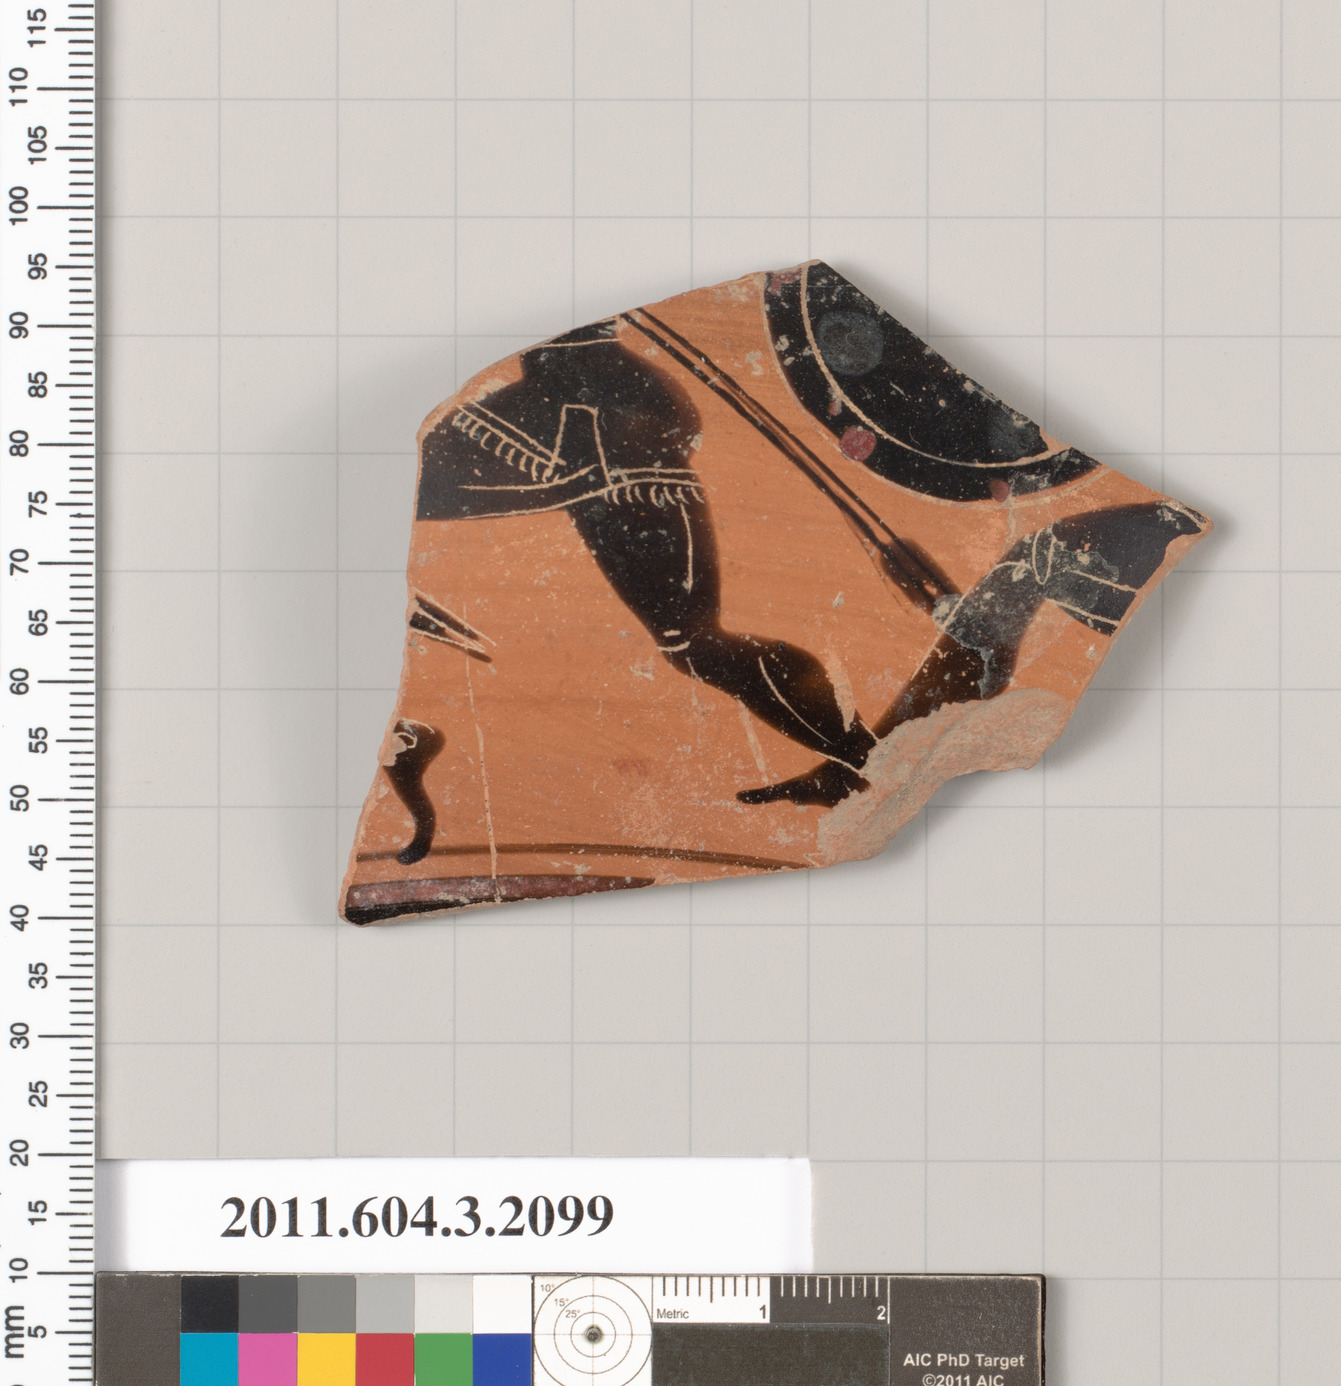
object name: kylix fragment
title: Terracotta fragment of a kylix (drinking cup)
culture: greek, attic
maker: heidelberg painter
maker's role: artist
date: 575-551 BCE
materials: terracotta